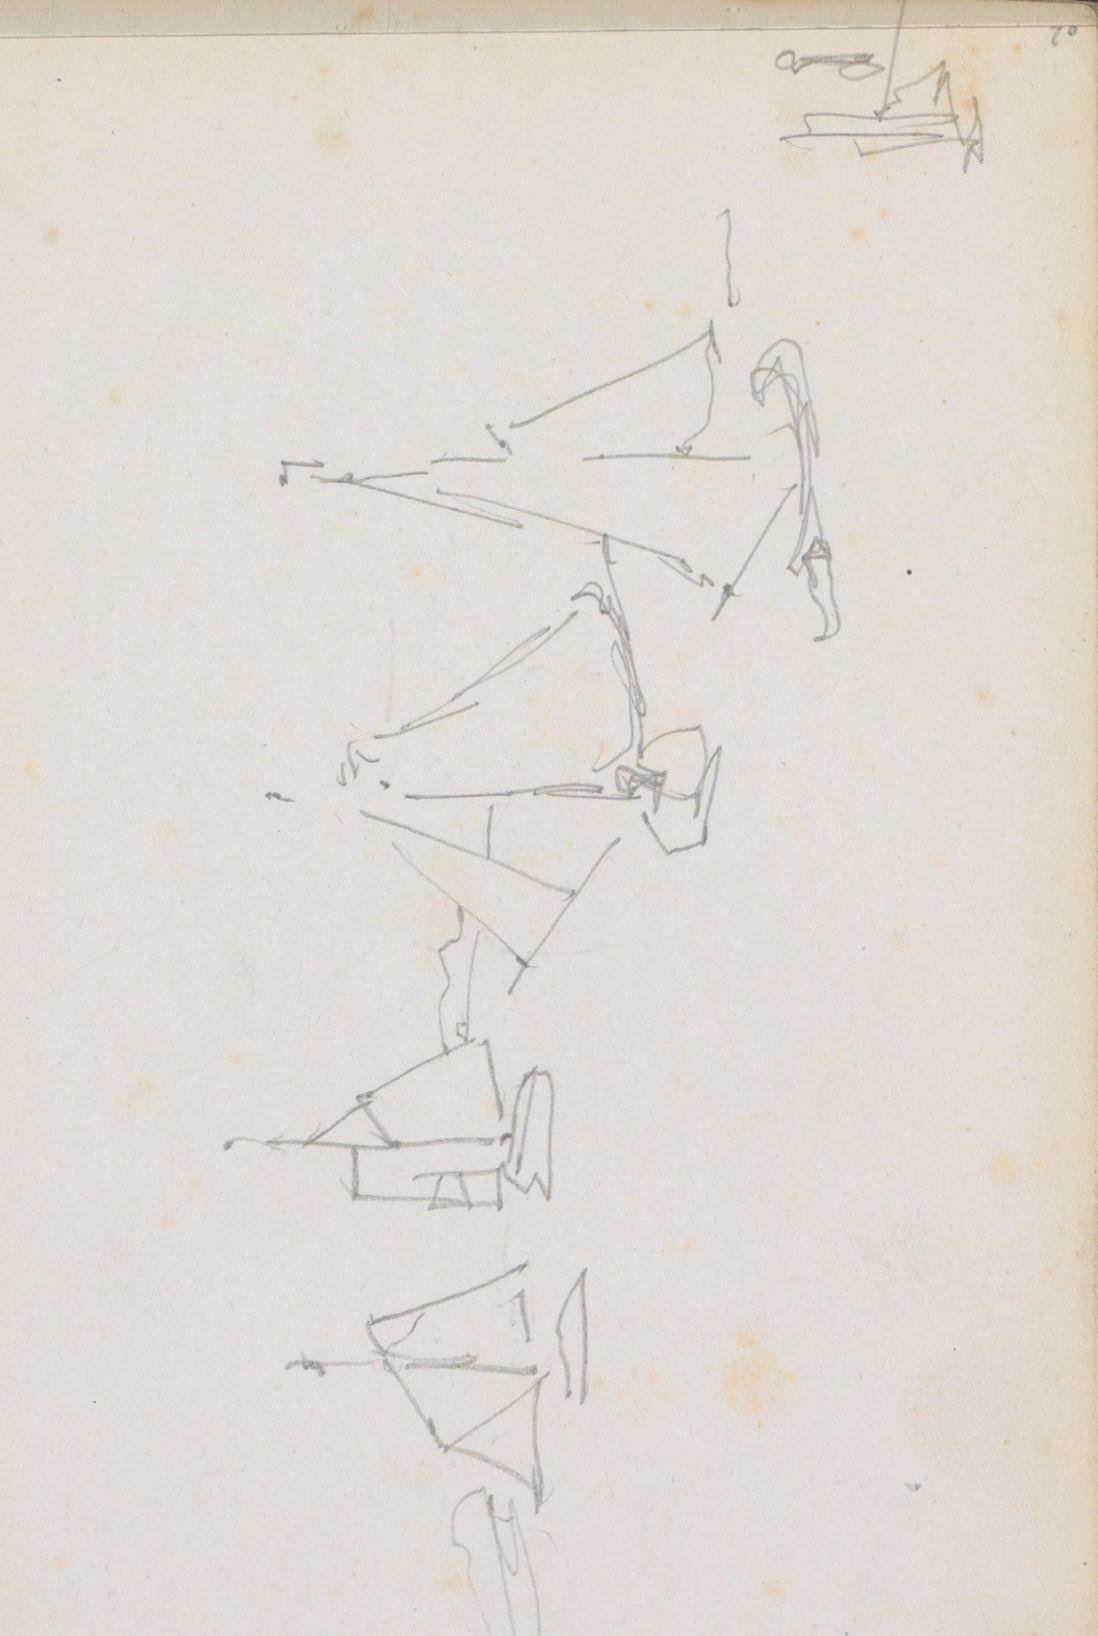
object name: sketchbook leaf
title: Zeilschepen op het water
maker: george hendrik breitner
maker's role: draughtsman, painter, print maker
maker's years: 1857-1923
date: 1880-1882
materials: paper, pencil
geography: south holland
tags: sailing-ship, sailing-boat, landscapes with waters, waterscapes, seascapes (in the temperate zone)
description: Pagina 70 uit een schetsboek met 72 bladen.